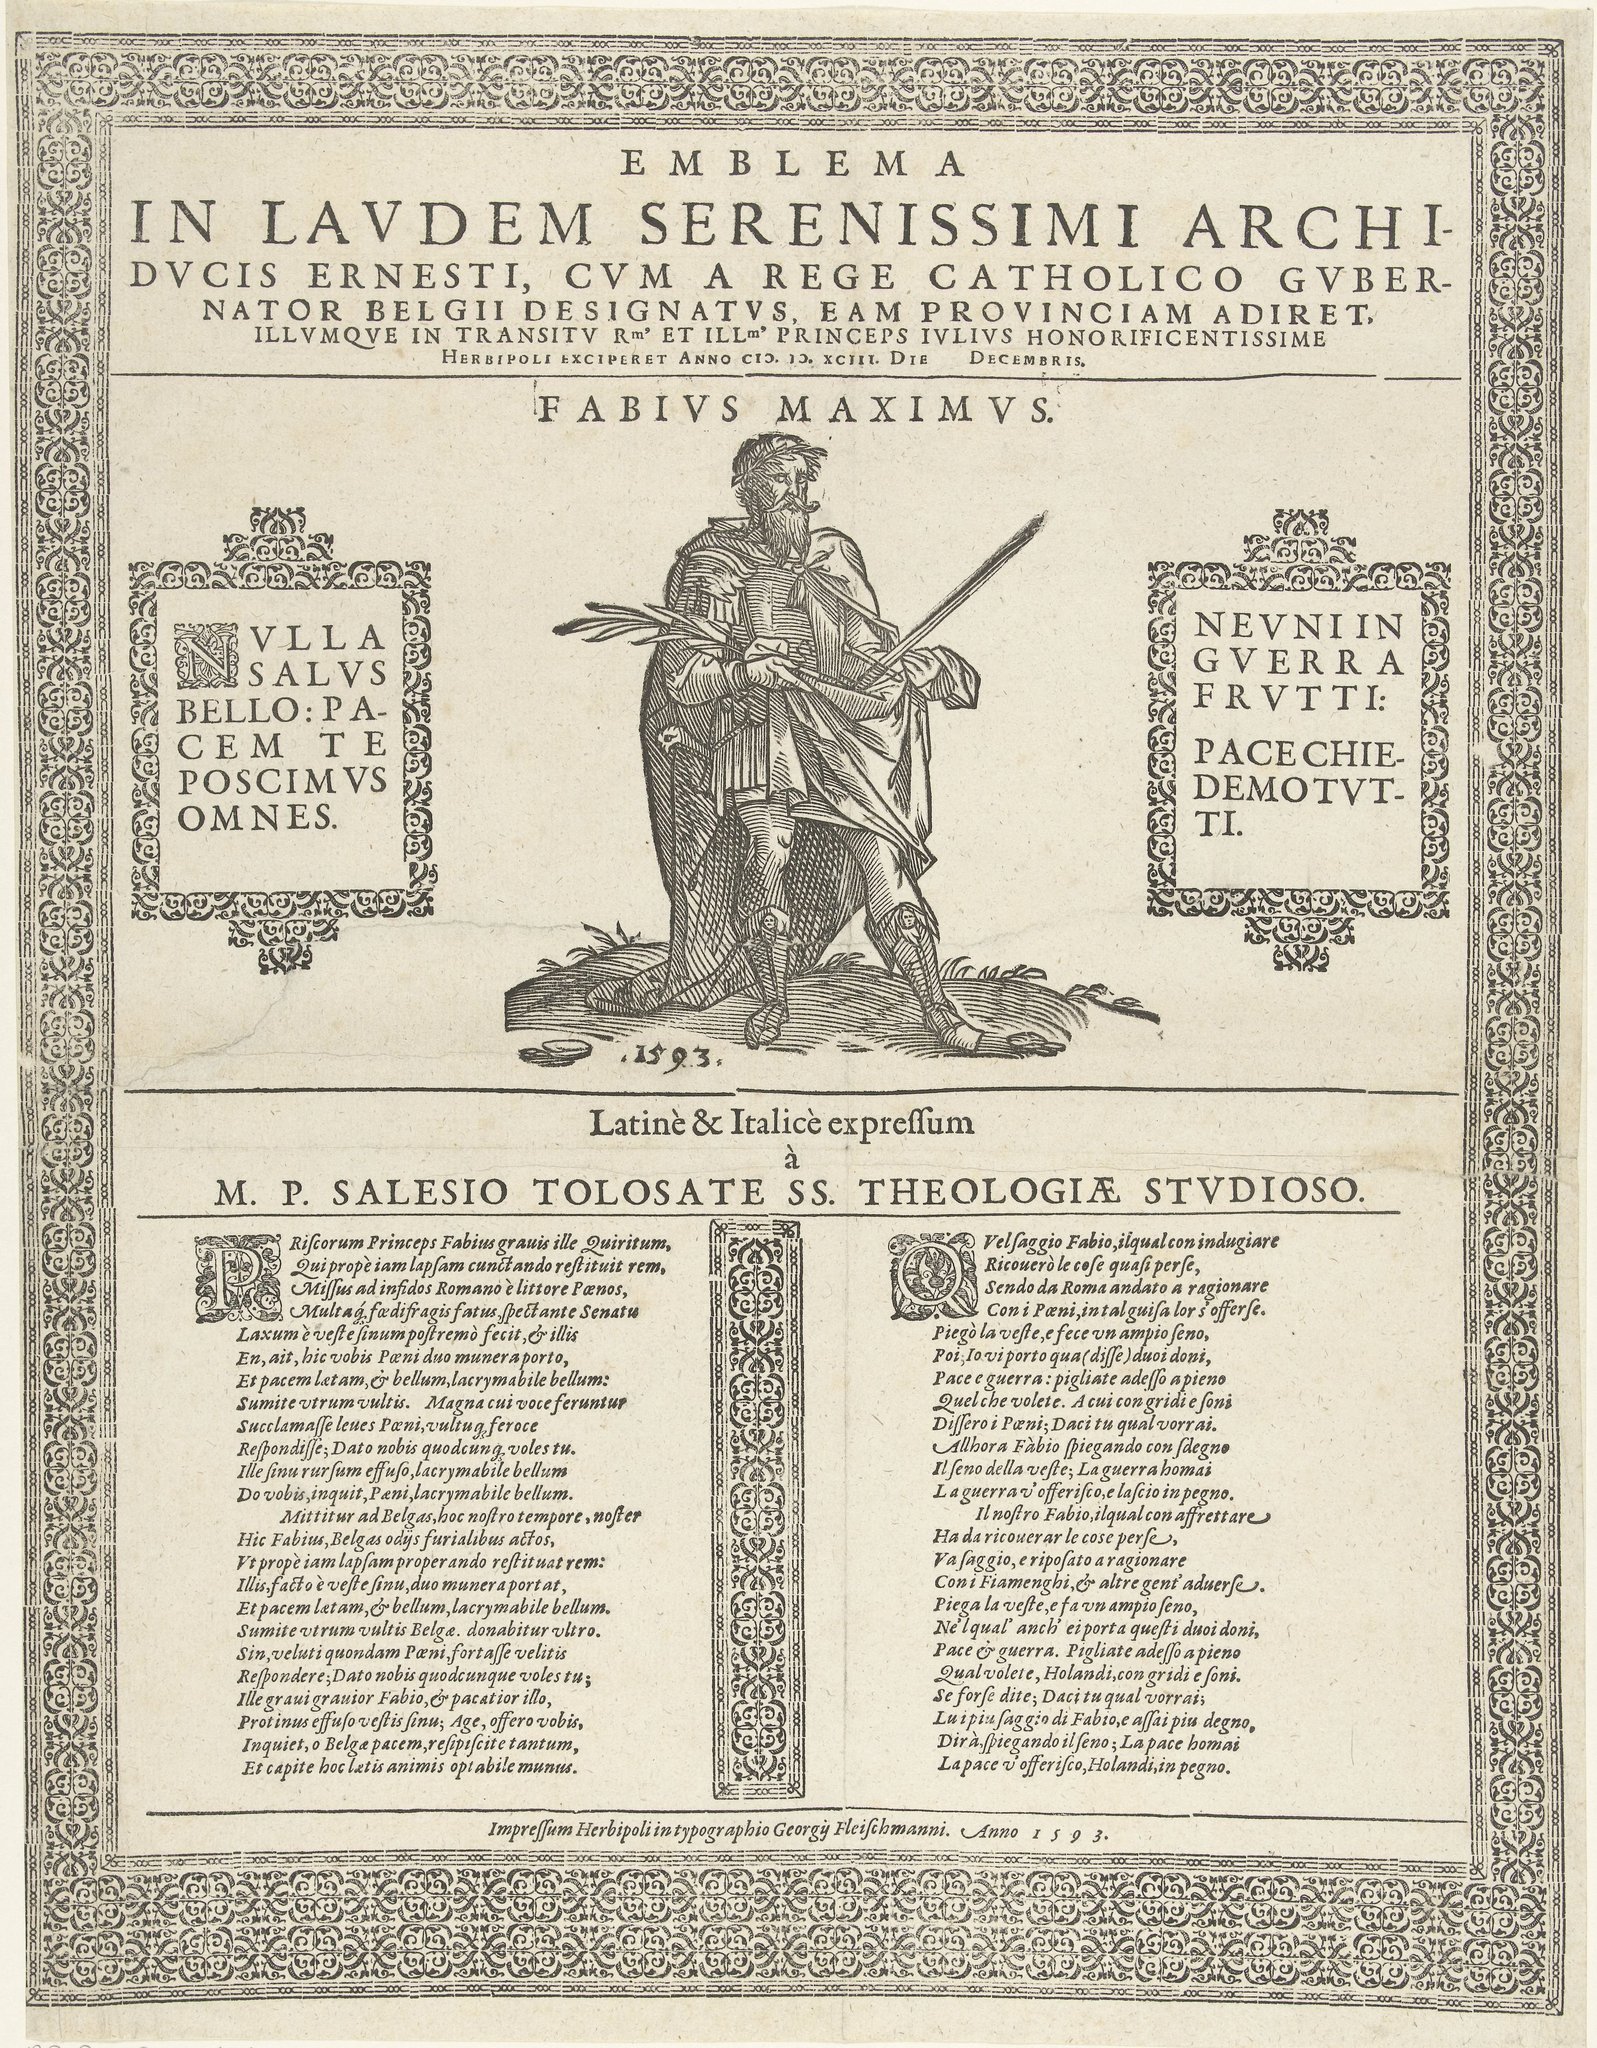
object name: print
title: Ernst van Oostenrijk aangesteld als landvoogd over de Zuidelijke Nederlanden, 1593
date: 1593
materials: paper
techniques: letterpress printing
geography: würzburg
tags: vienna, quintus fabius maximus, surnamed cunctator, gives the council of carthage the choice between war and peace; he is seen gathering the folds of his toga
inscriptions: date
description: Blad naar aanleiding van de aanstelling van Ernst van Oostenrijk als landvoogd over de Zuidelijke Nederlanden, 1593. Fabius Maximus met zwaard en vredestak in zijn opgehouden toga. Met cartouches met teksten in het Latijn. Het blad heeft een versierde rand.